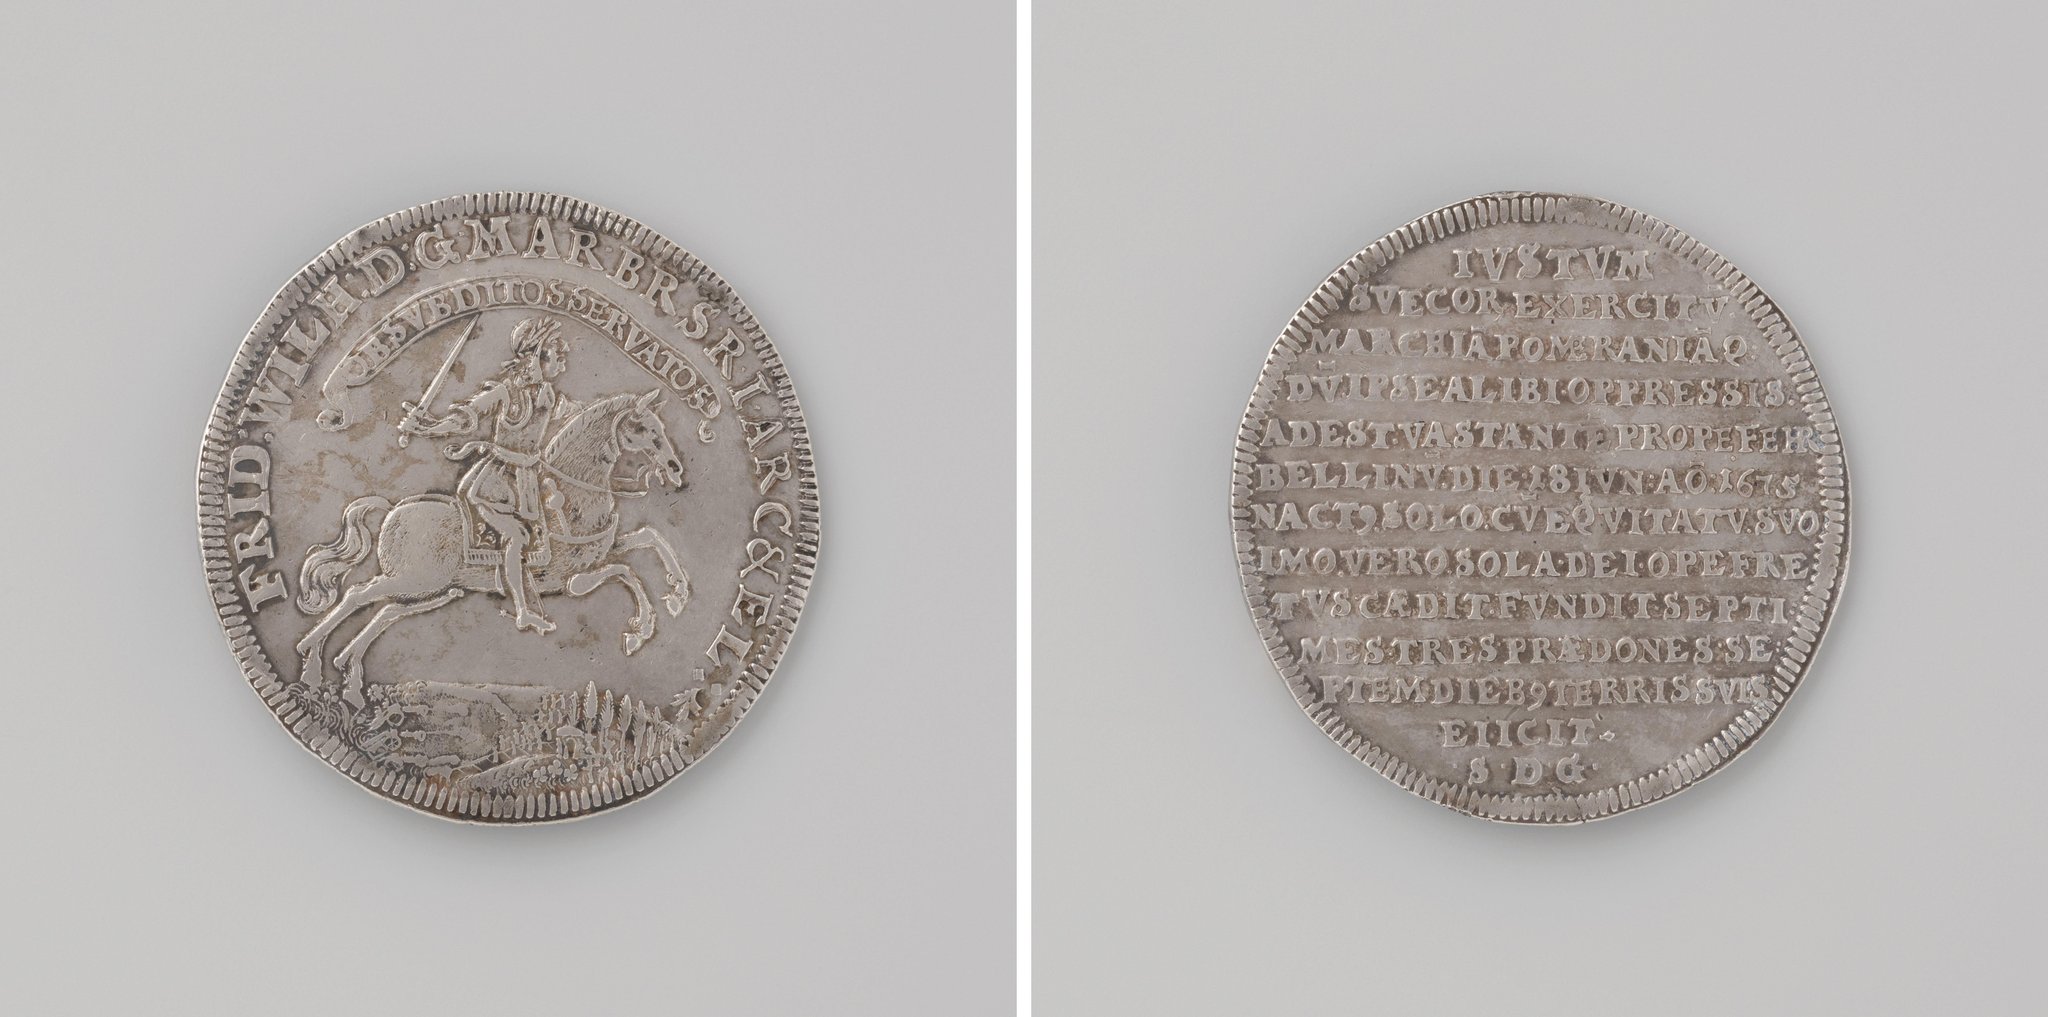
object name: history medal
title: Overwinning op de Zweden bij Ferbellin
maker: Anonymous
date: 1675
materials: silver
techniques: striking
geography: germany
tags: berlin, frederik willem van brandenburg (i)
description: Zilveren penning. Voorzijde: portret man te paard met getrokken zwaard met op achtergrond strijdende legers onder wimpel met opschrift binnen omschrift. Keerzijde: opschrift.